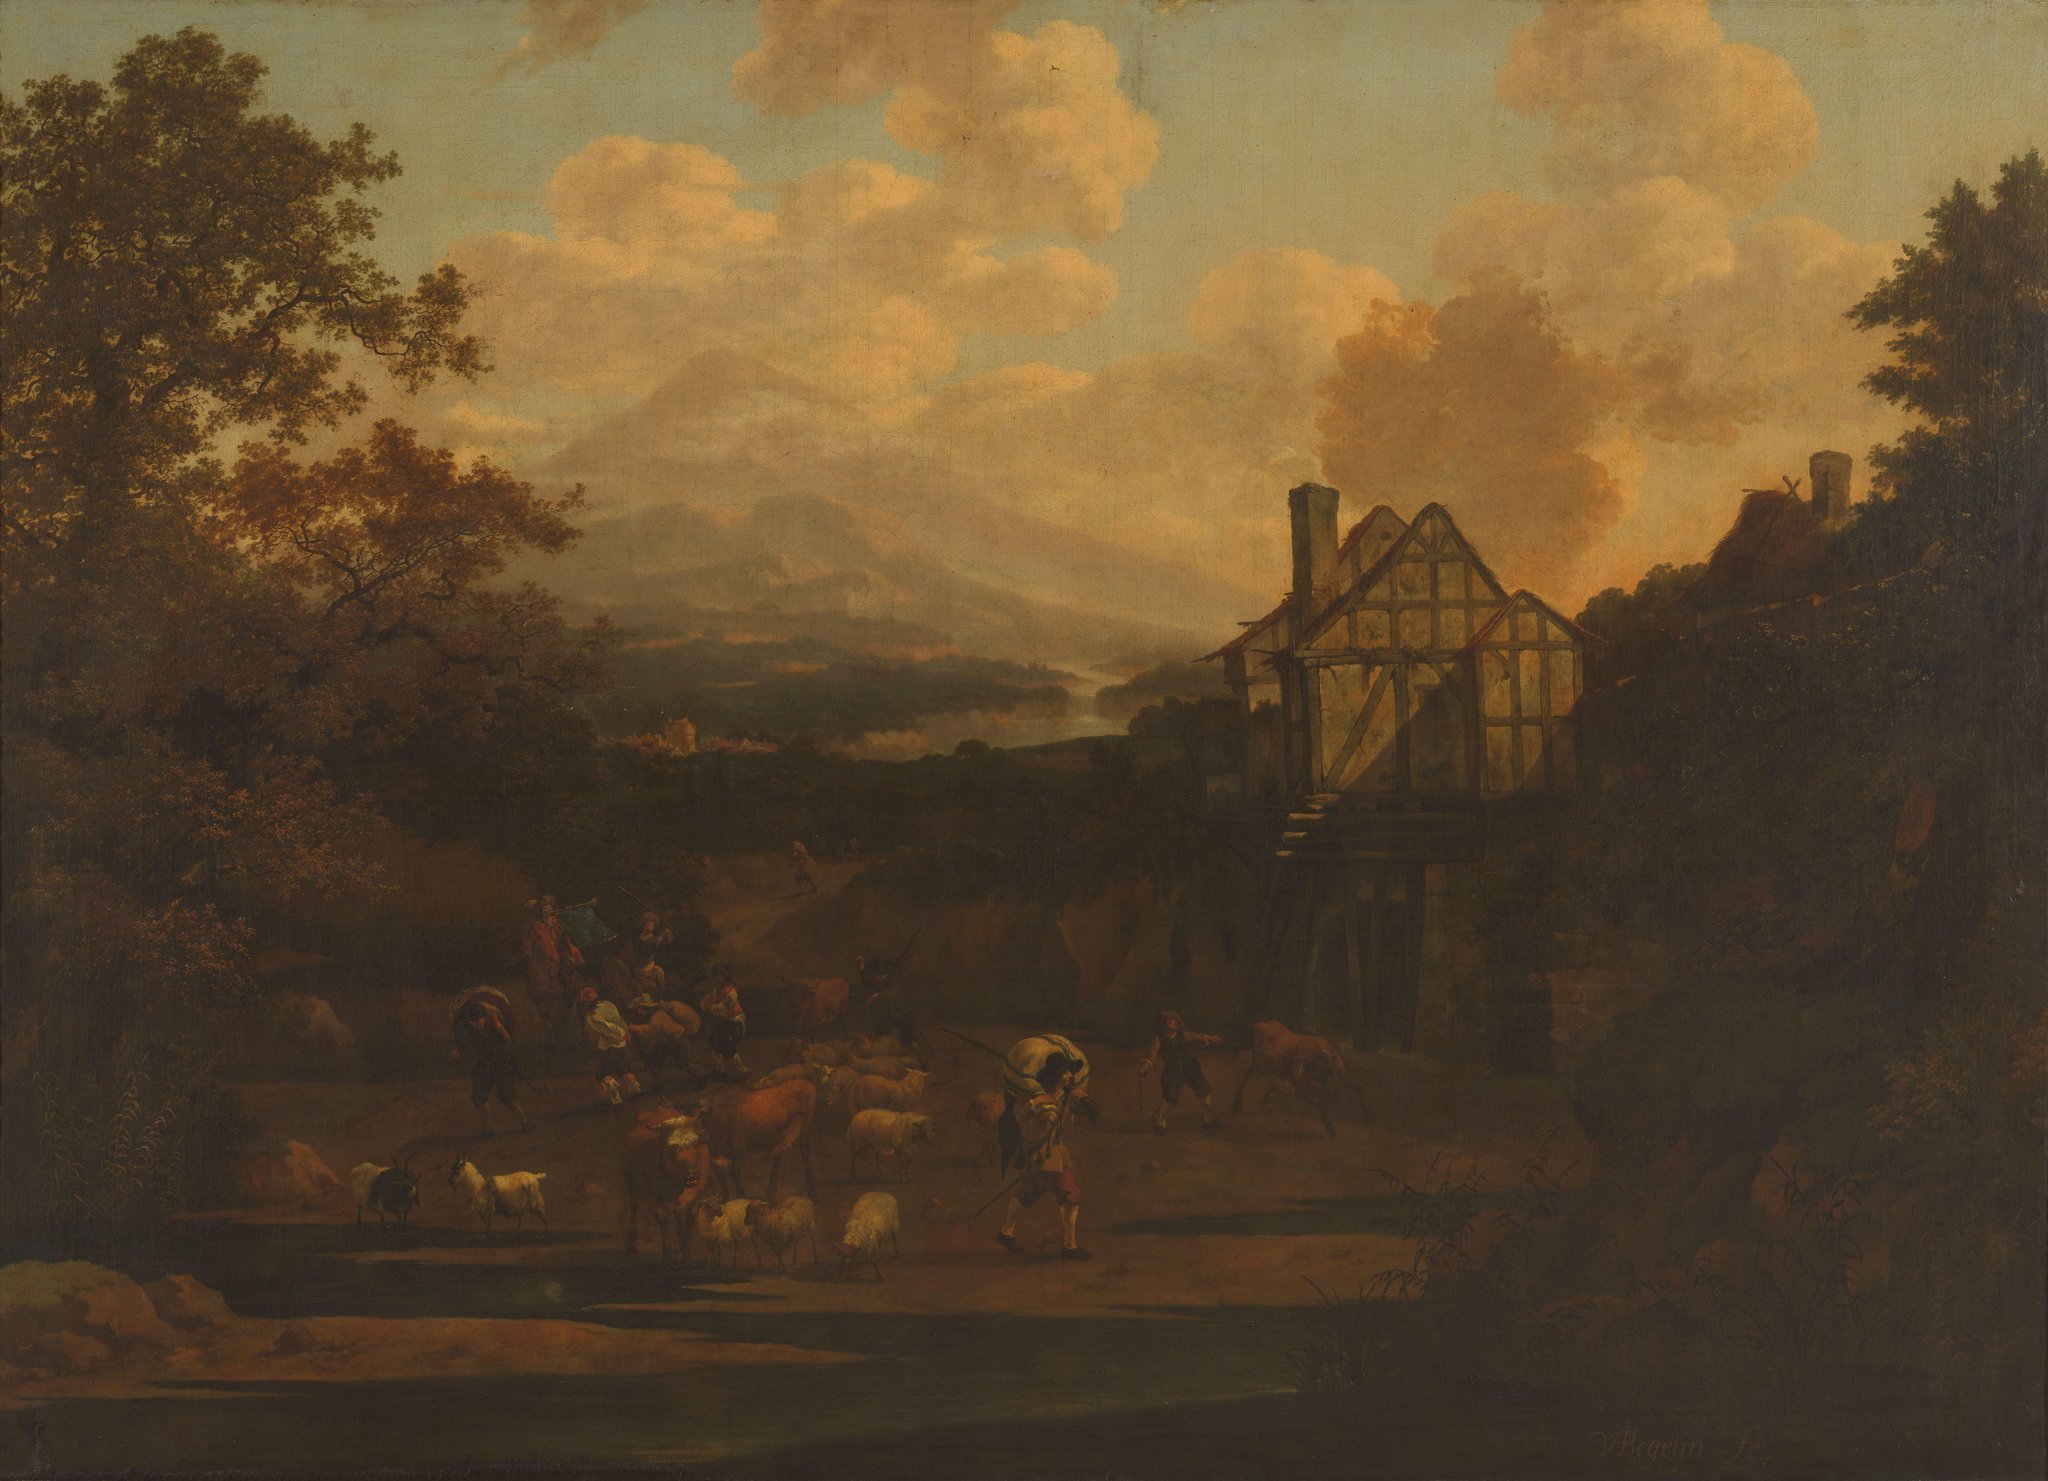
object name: painting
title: Plundering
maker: abraham jansz begeyn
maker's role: draughtsman, print maker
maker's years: 1637-1697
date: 1650-1697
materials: canvas, oil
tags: traveller(s) attacked by robber(s), robbery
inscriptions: signature: ‘ABgeijn. fe:’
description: Landschap waarin veedrijvers onderweg worden overvallen en beroofd door een groep rovers.